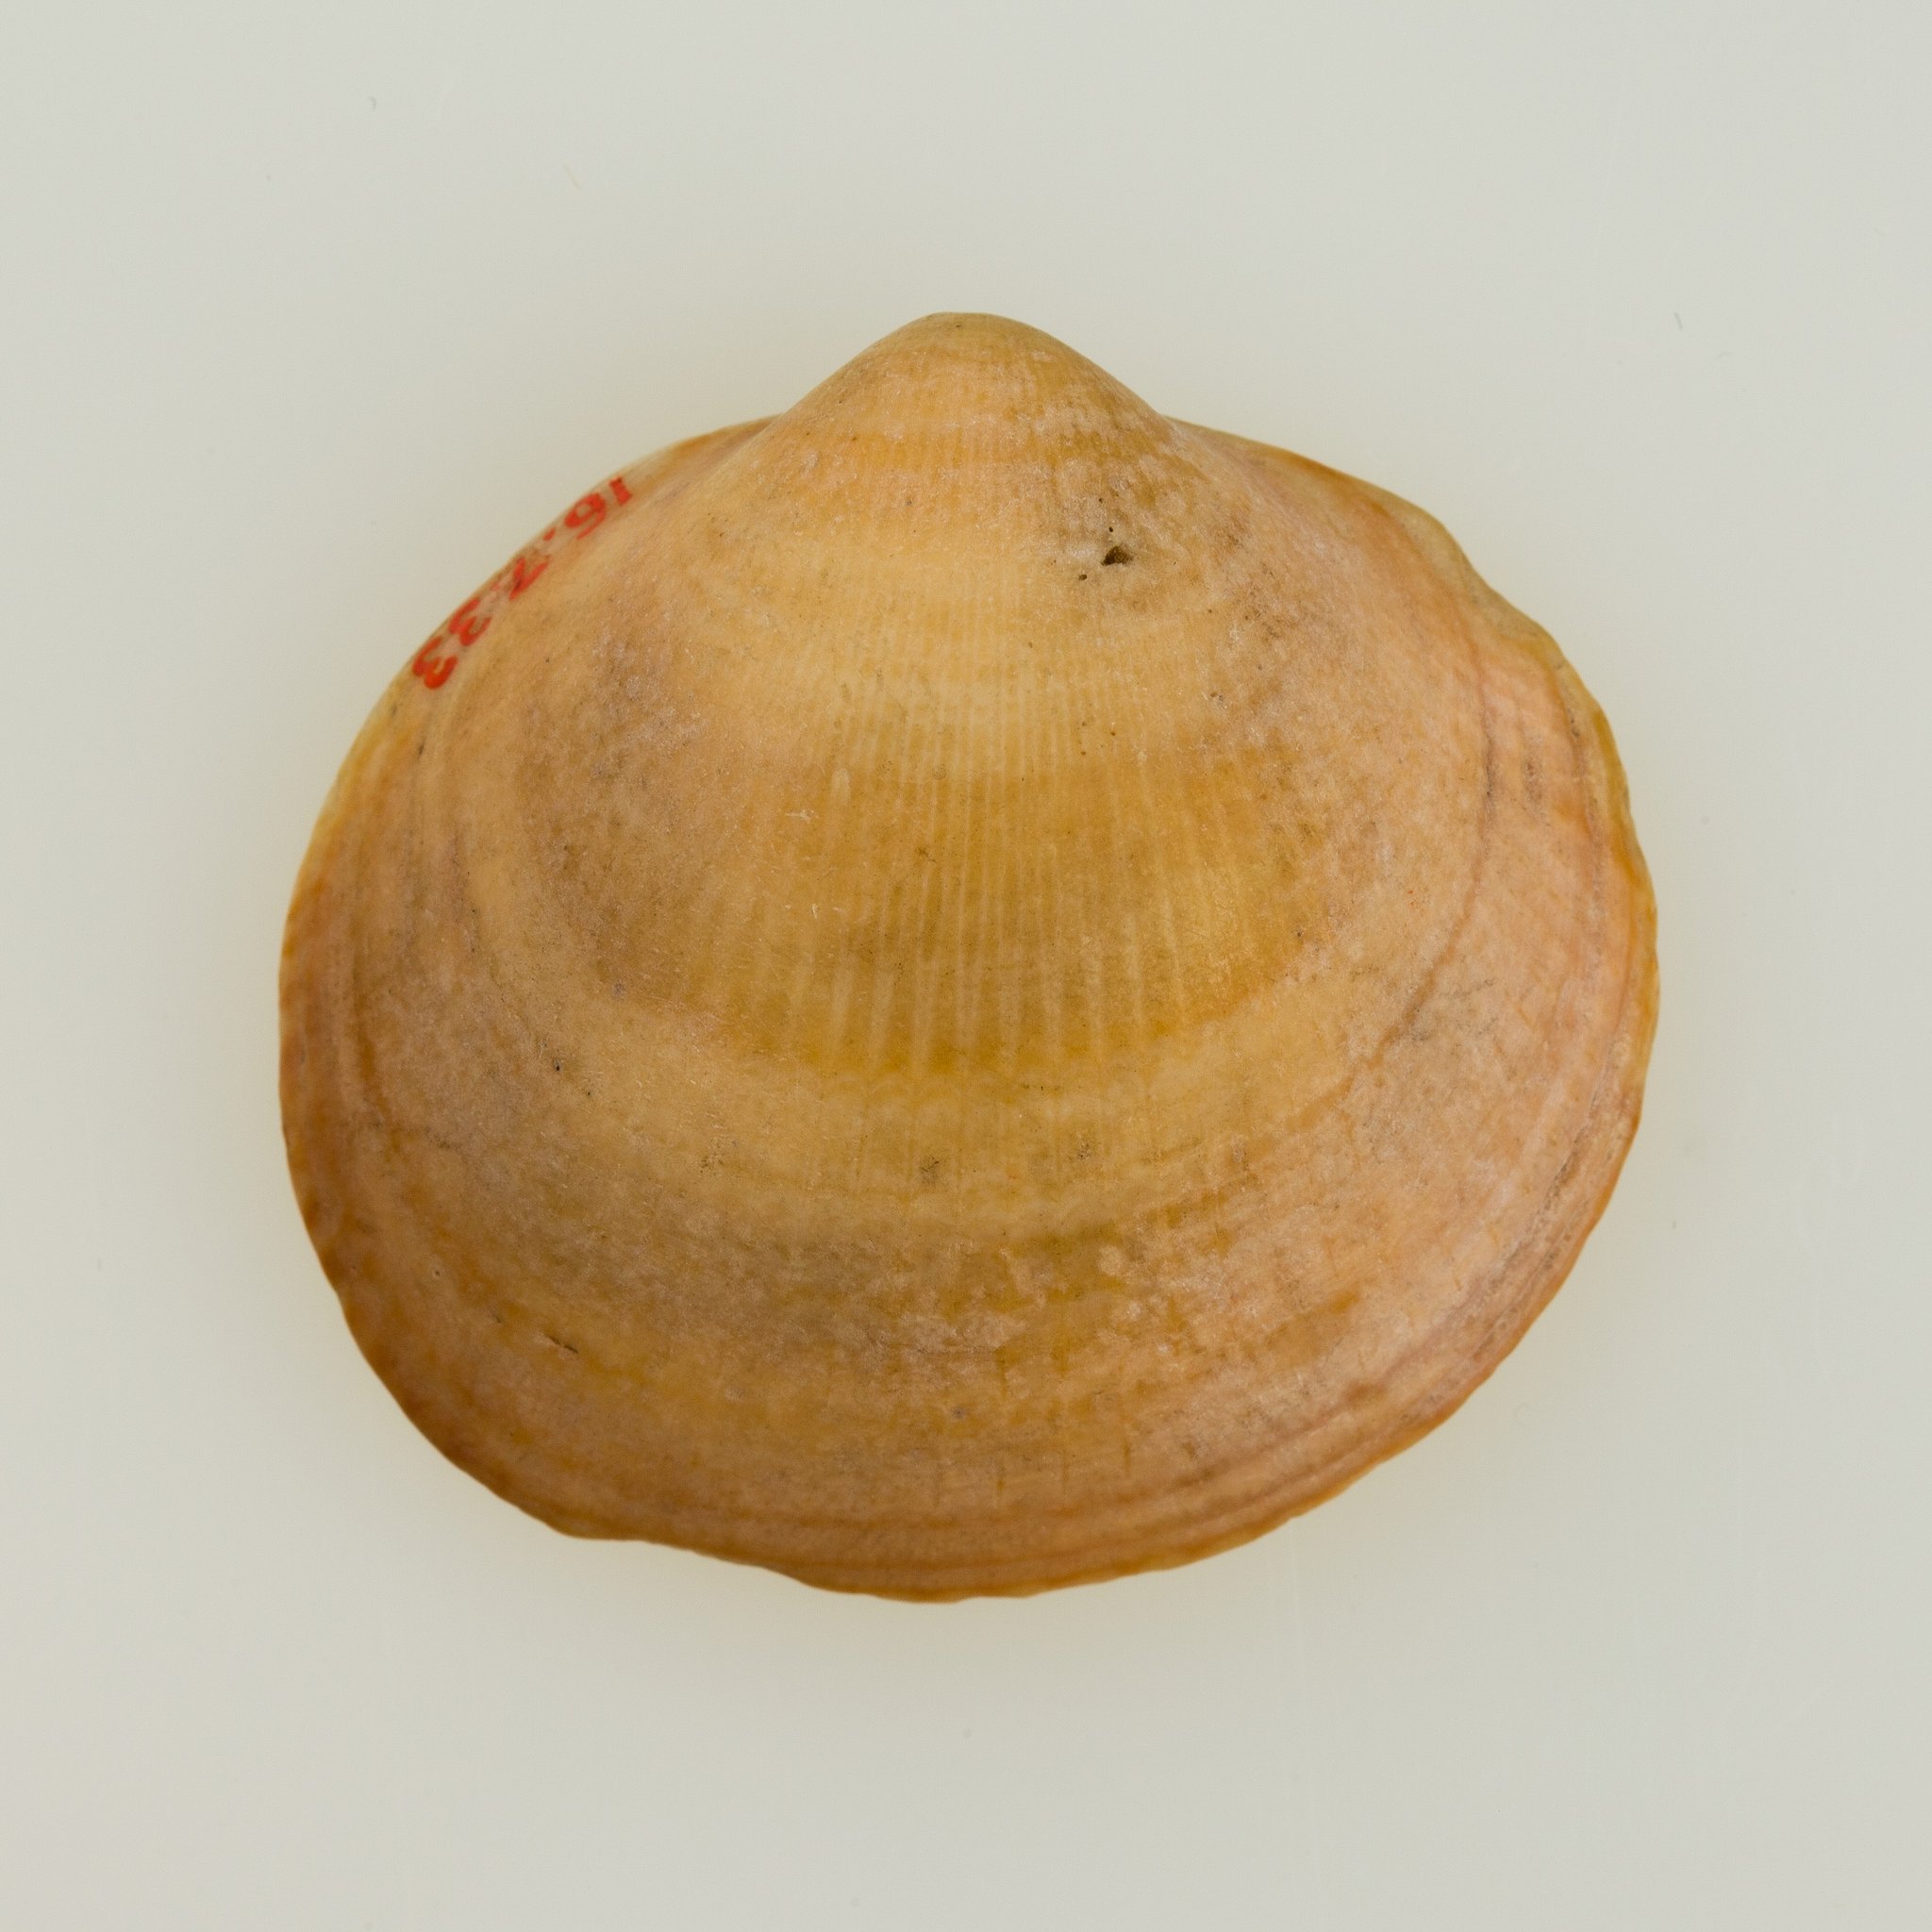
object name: pendant, shell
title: Shell pendant or bead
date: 3850-2960 BCE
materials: shell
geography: egypt